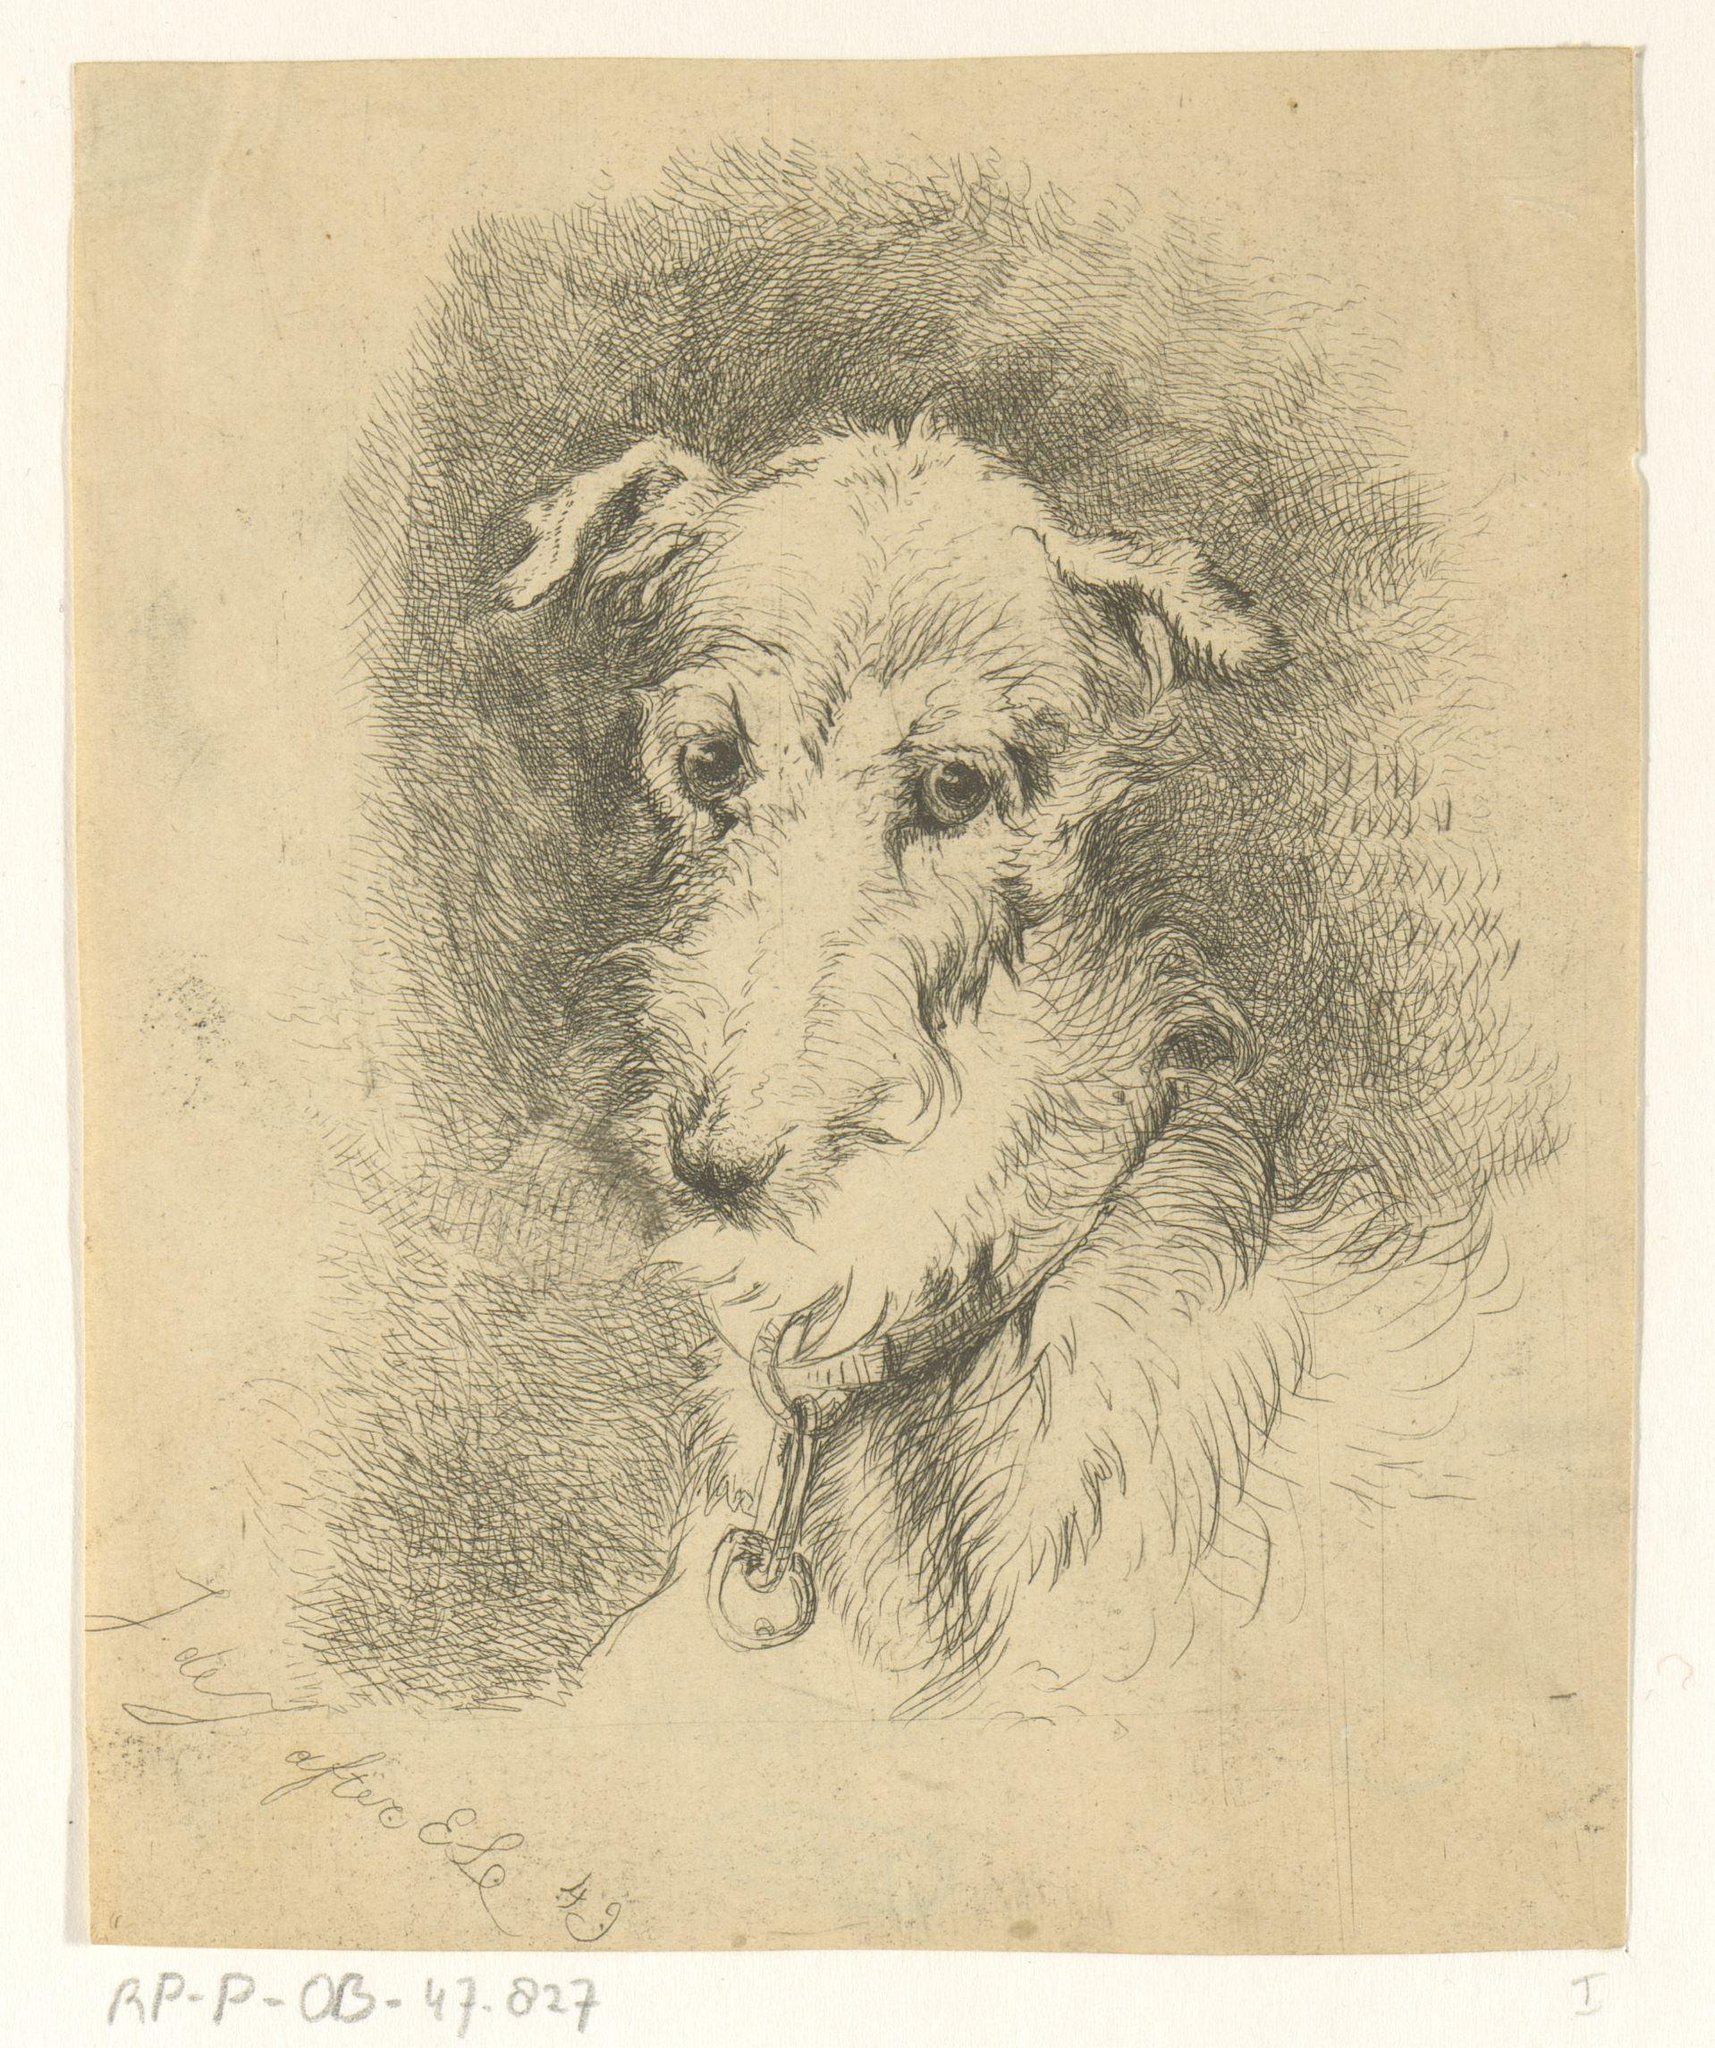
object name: print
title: Kop van hazewindhond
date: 1849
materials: paper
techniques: etching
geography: the hague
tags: dog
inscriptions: collector's mark: Lugt 2228